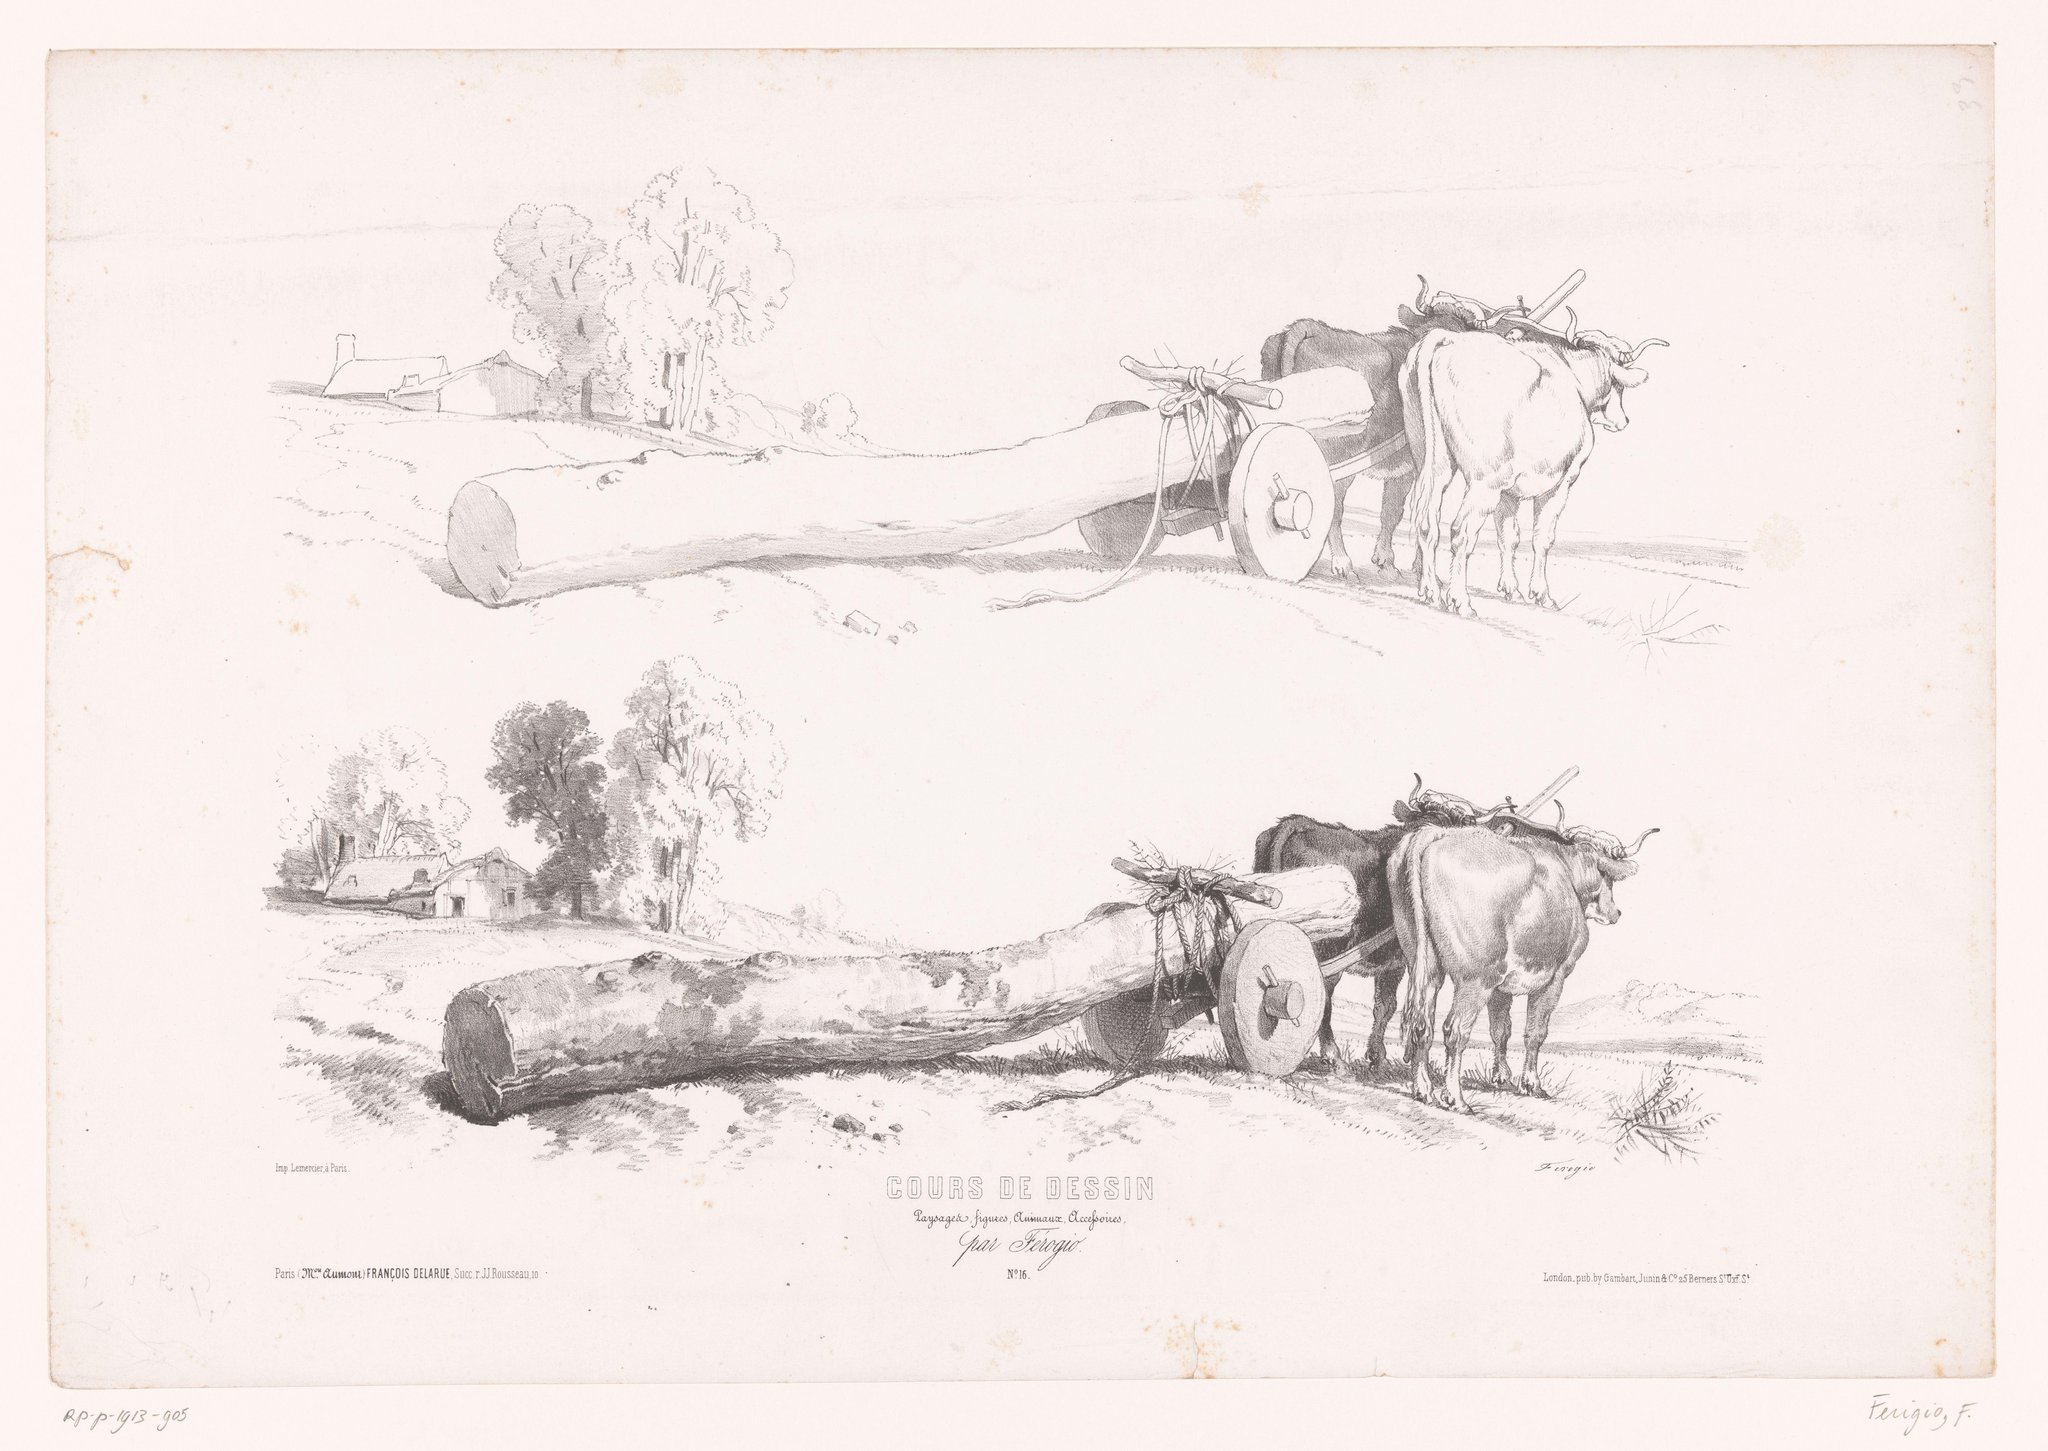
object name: print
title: Cours de dessin. Paysages, figures, animaux, accessoires, par Férogio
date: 1845-1846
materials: paper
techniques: lithograph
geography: paris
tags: trees (+ stem, trunk), bovine cattle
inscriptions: collector's mark: Lugt 2228a